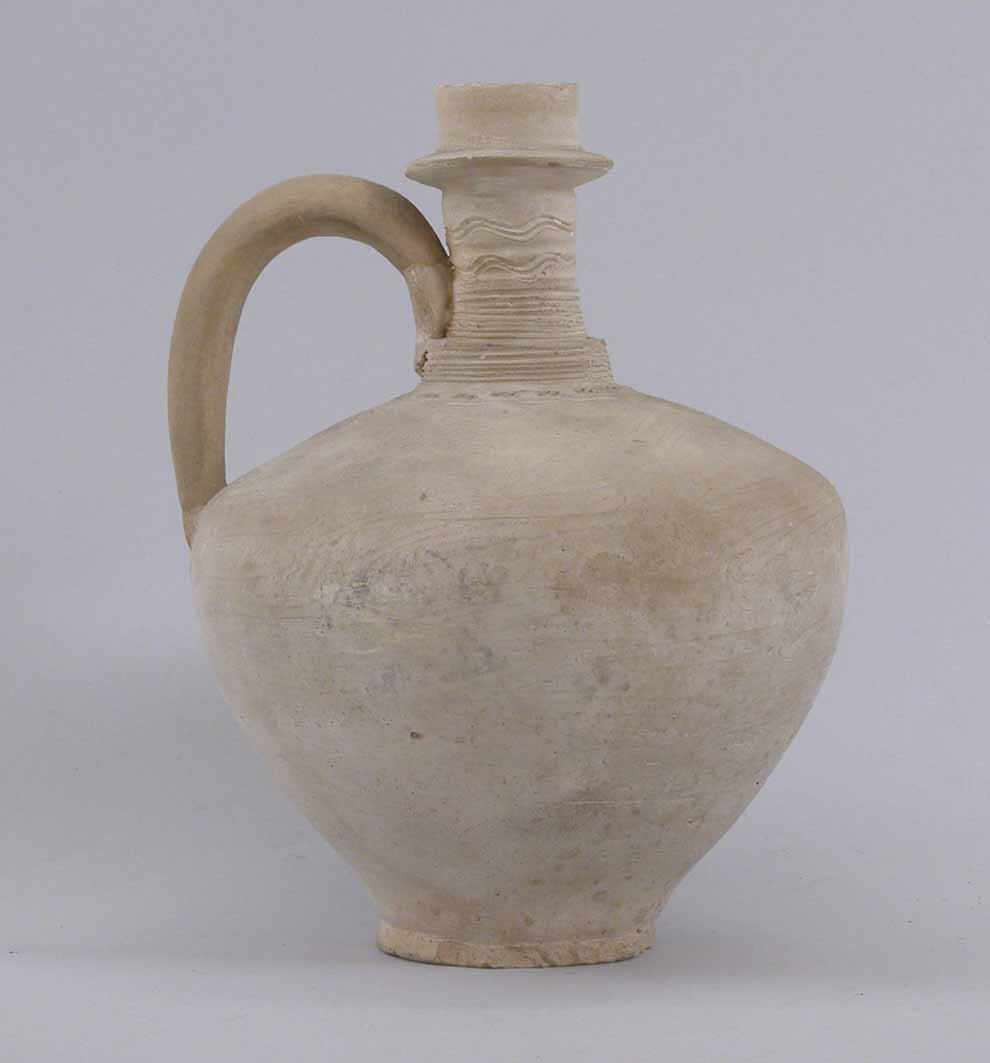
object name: jug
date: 801-1000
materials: earthenware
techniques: incising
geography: iran